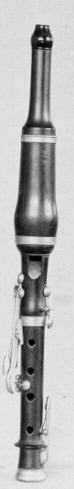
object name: flageolet in a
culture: french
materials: mother of pearl, nickel, silver, wood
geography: france